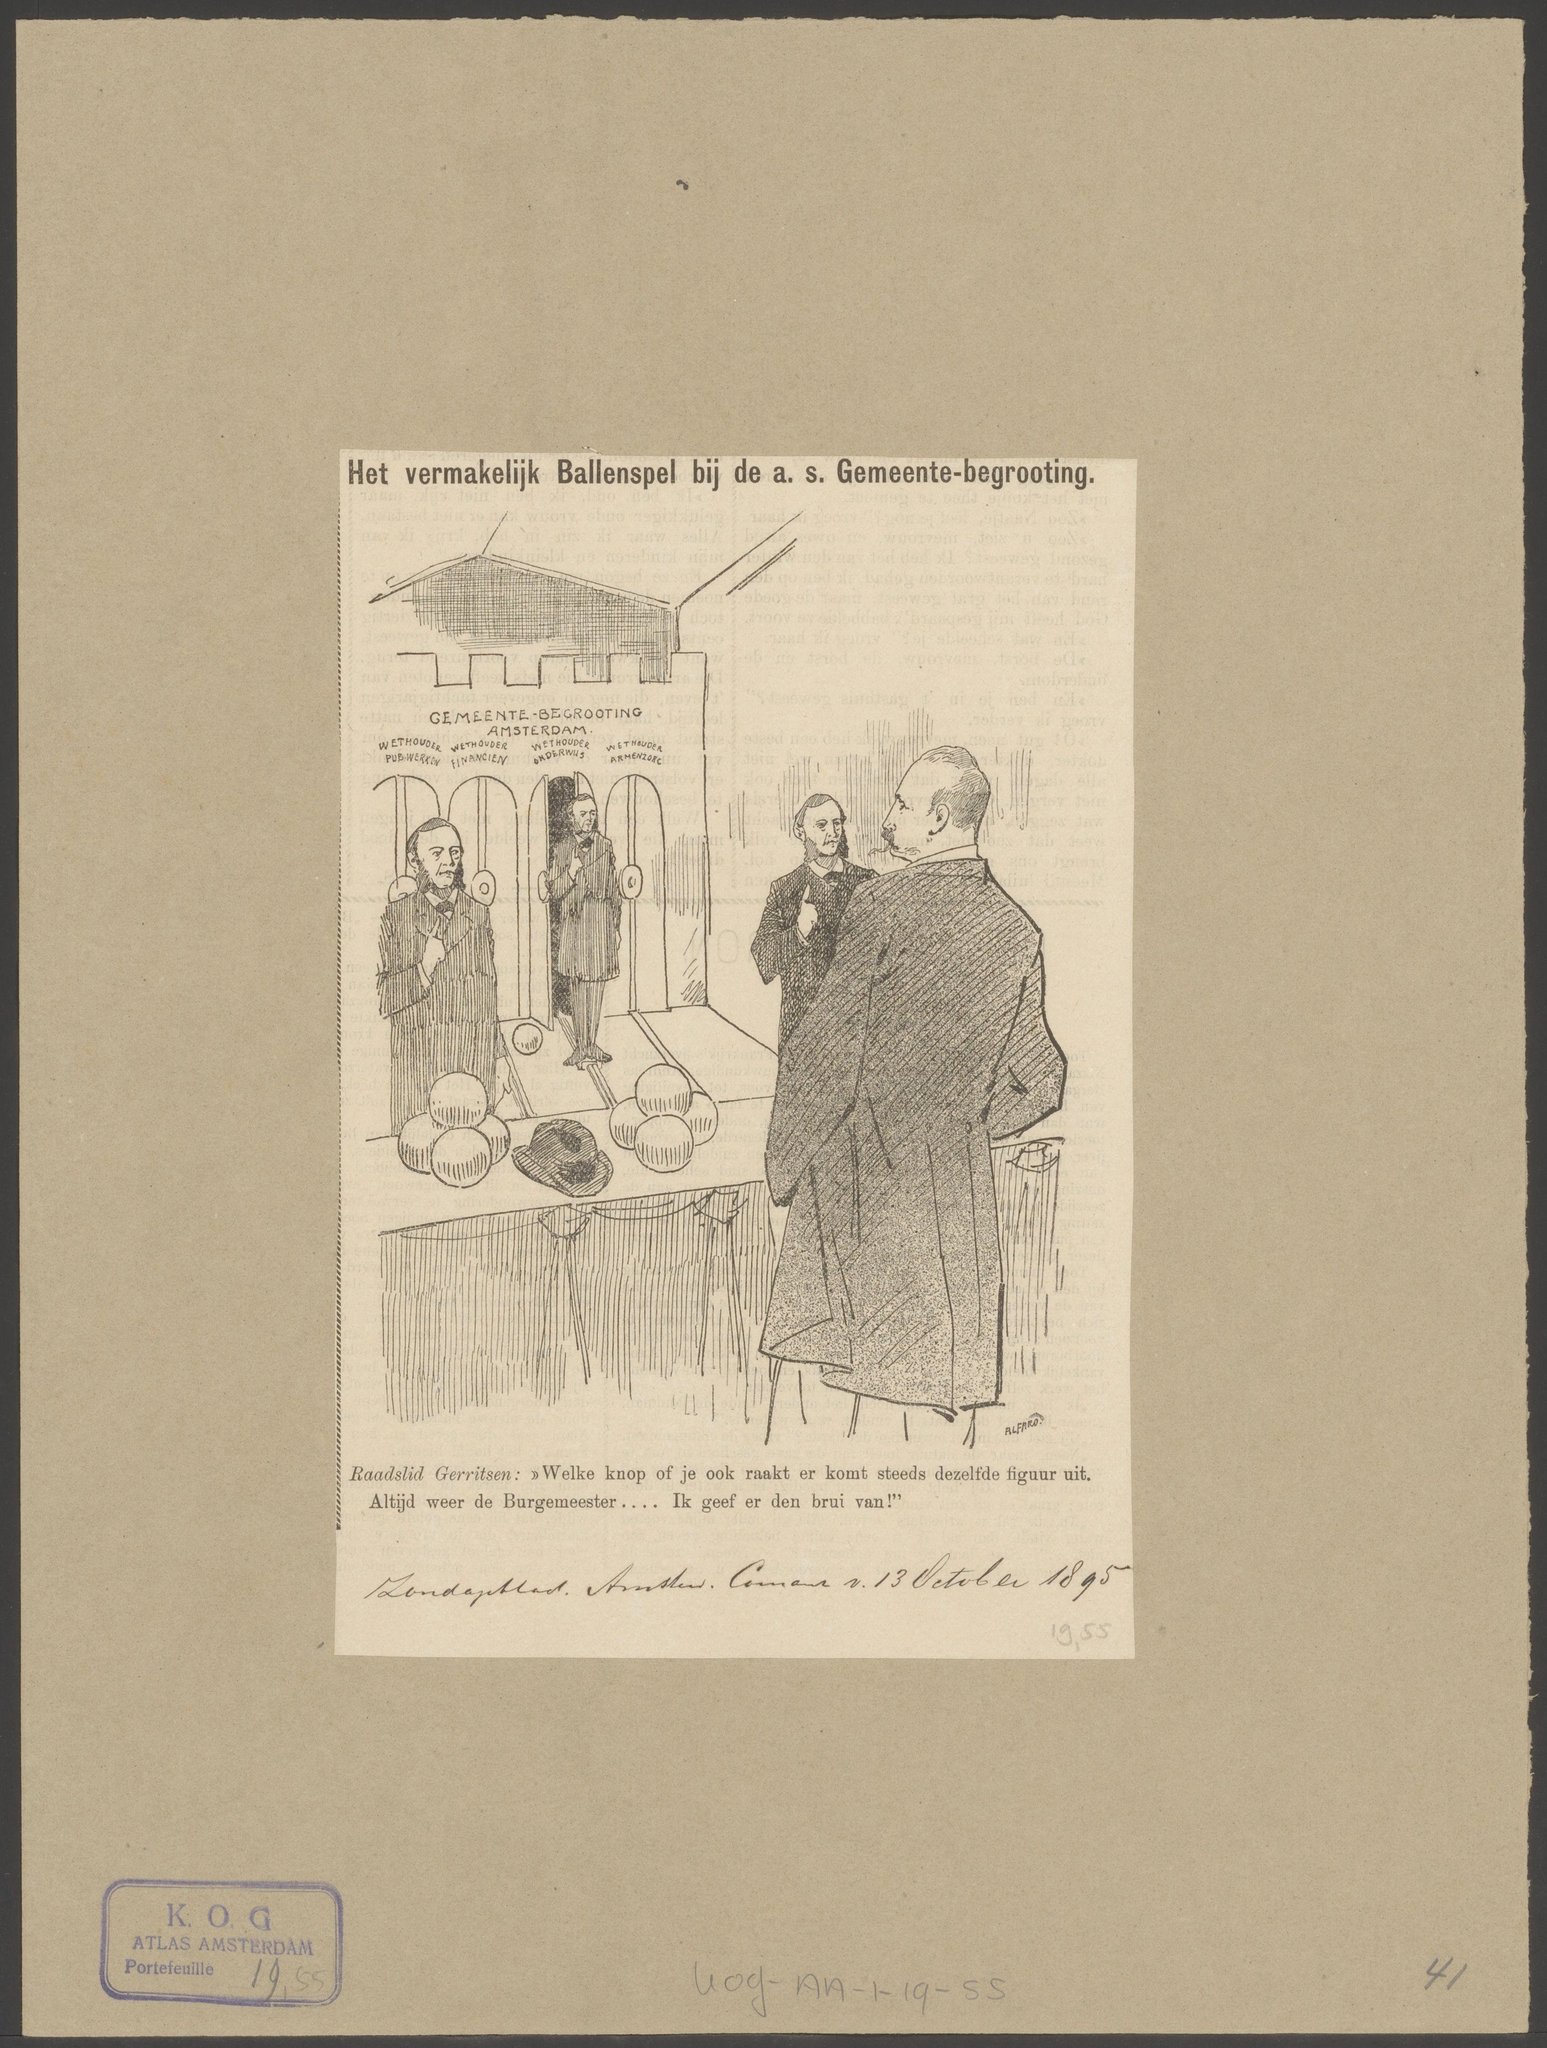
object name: cartoon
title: Spotprent op Sjoerd Vening Meinesz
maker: alfaro reijding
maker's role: draughtsman, engineer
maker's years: 1863-1930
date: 1895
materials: paper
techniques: letterpress printing, line block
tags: harlingen, politician, mayor, burgomaster, political caricatures and satires, amsterdam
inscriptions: collector's mark: ‘19,55’ Lugt 1641b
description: Onderwerpsrubriek binnen de Atlas Amsterdam: Herinneringen aan regeringsleden en hunne huisgezinnen [na 1800].